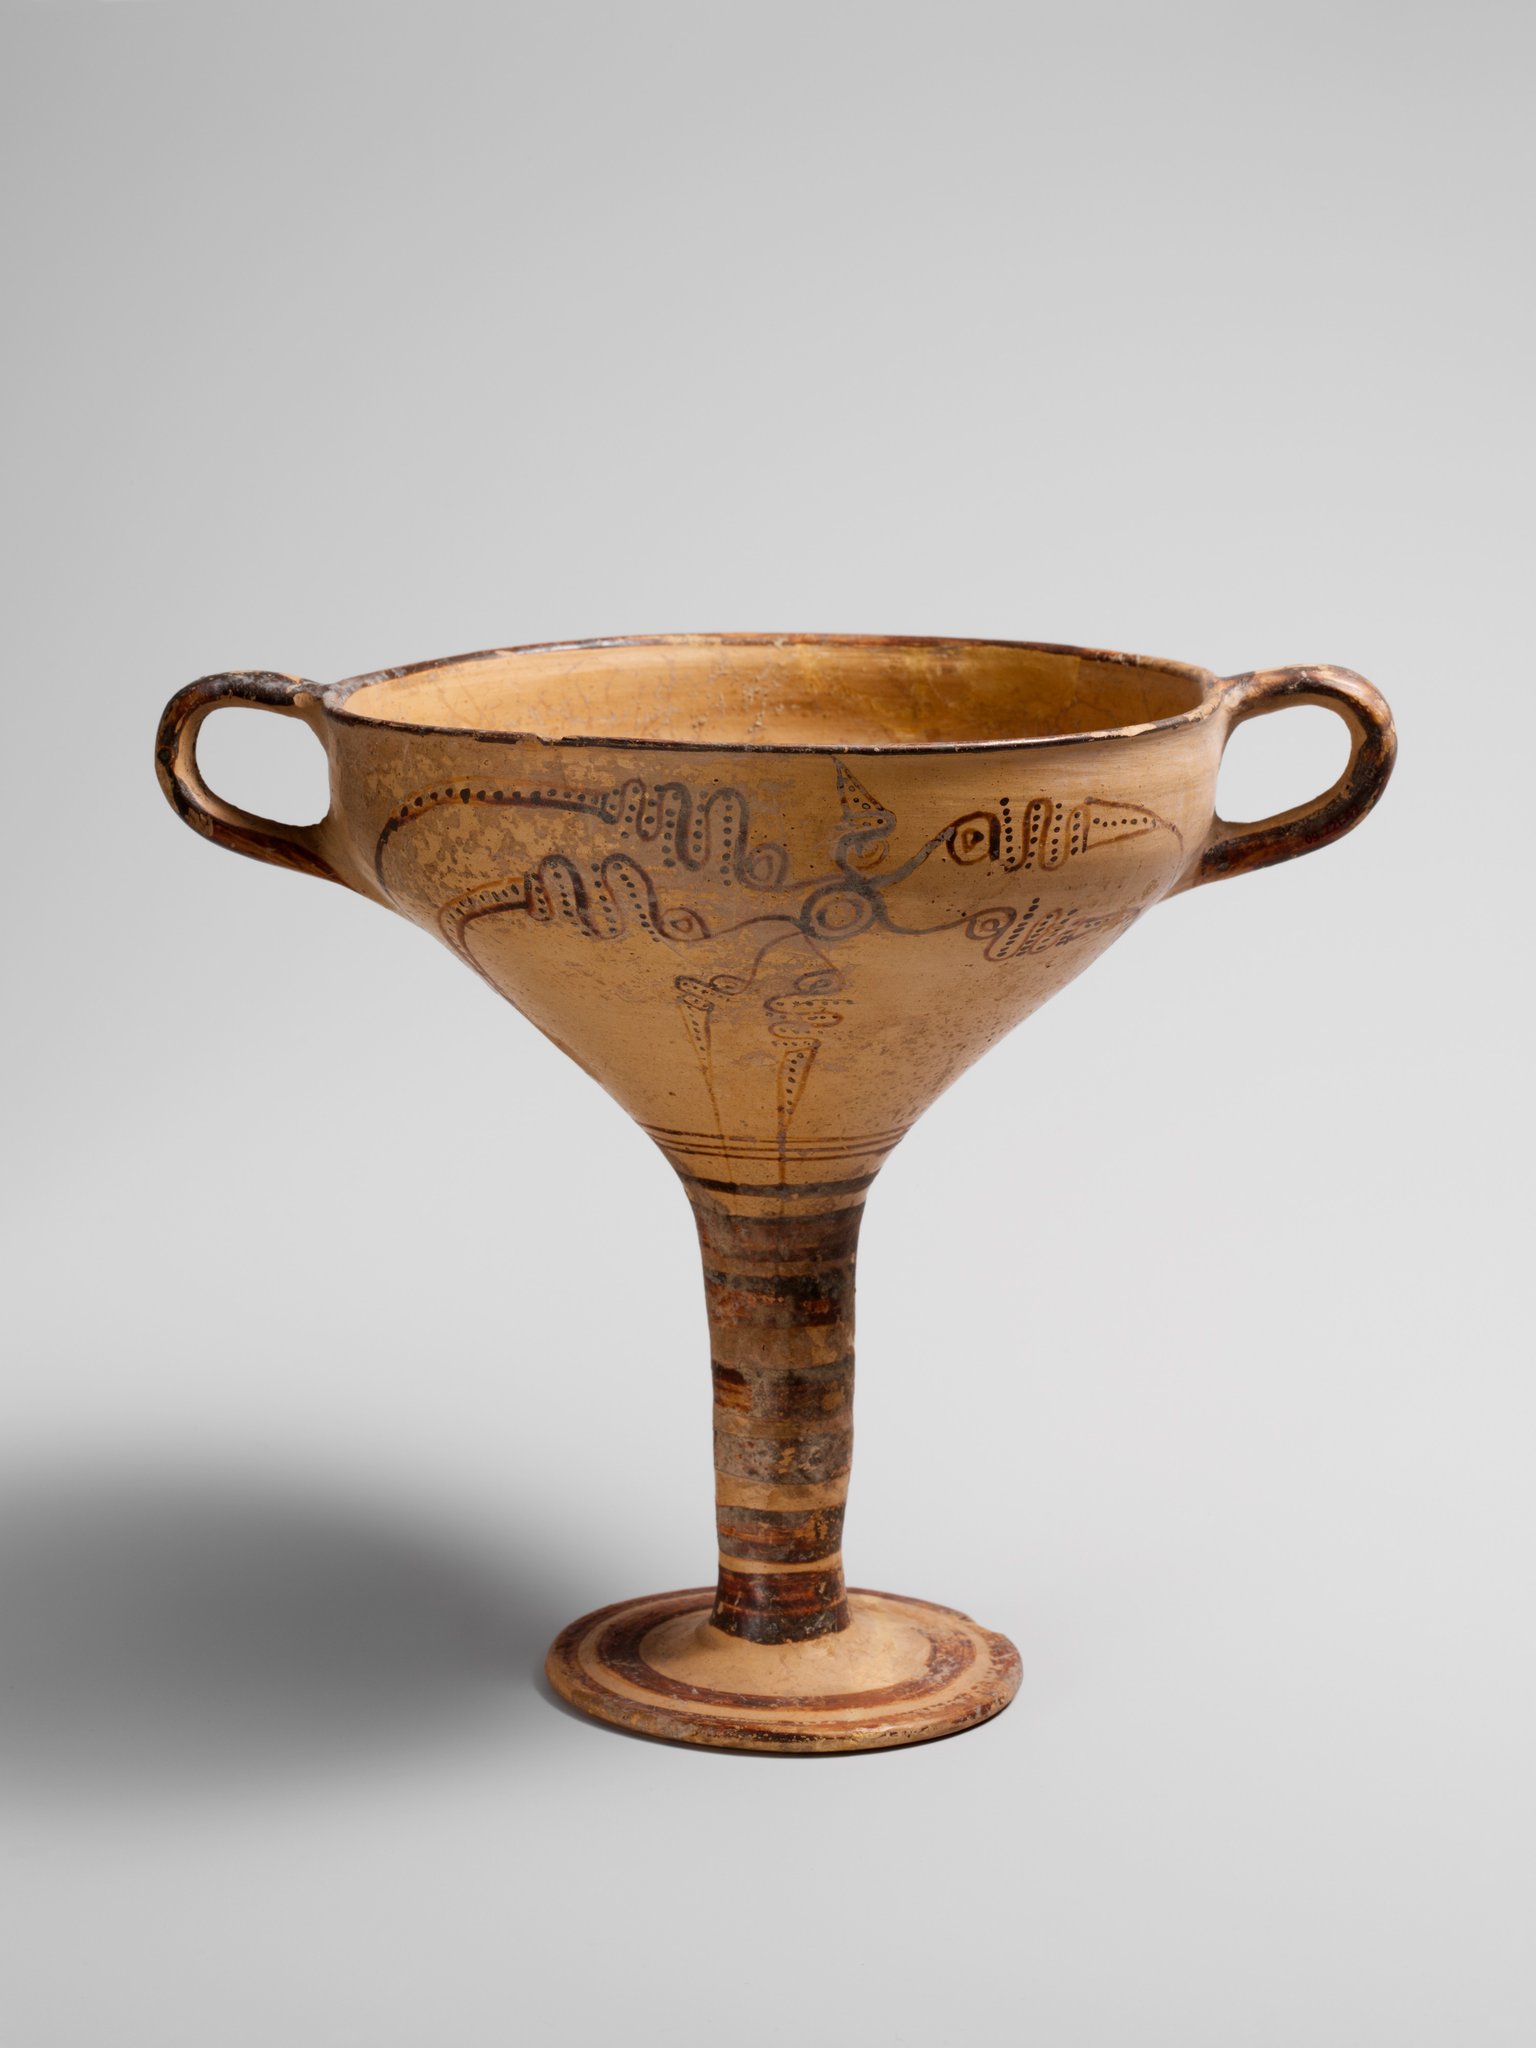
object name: cup, stemmed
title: Terracotta stemmed cup with murex decoration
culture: aegean, helladic or mycenaean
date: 1400-1300 BCE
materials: terracotta